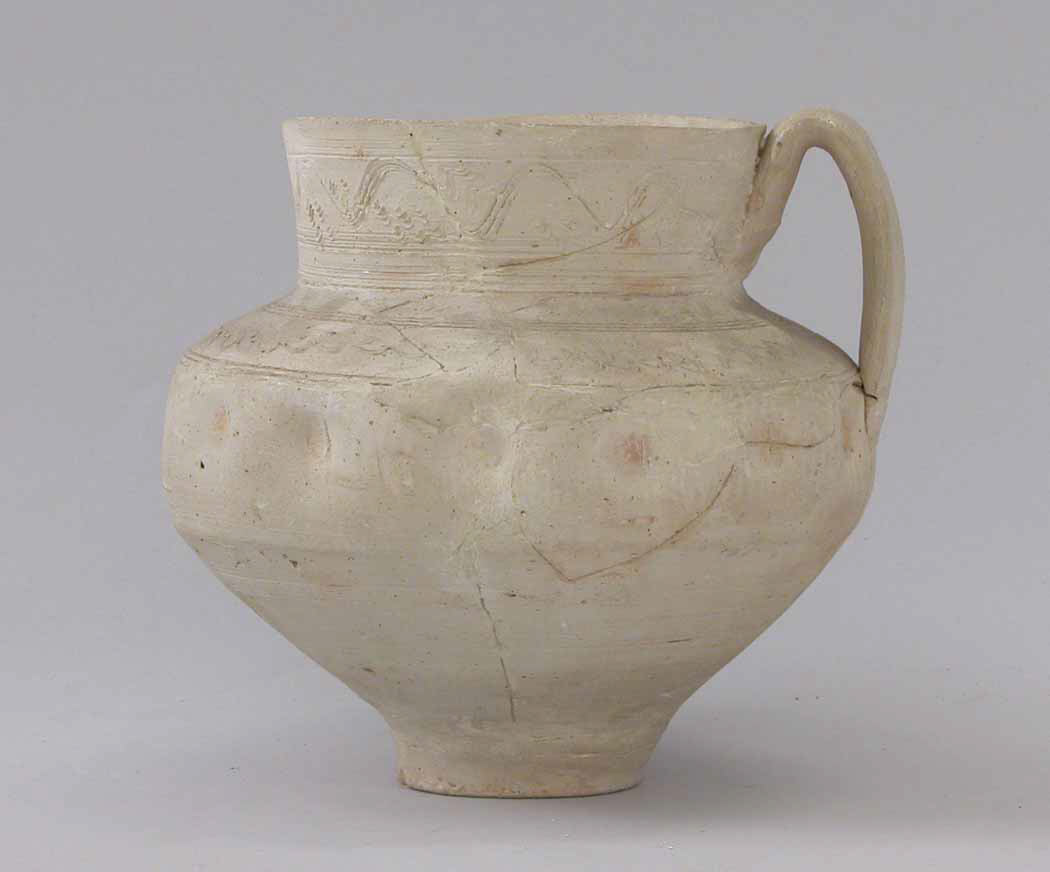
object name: jar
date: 901-1000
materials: earthenware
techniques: incising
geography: iran